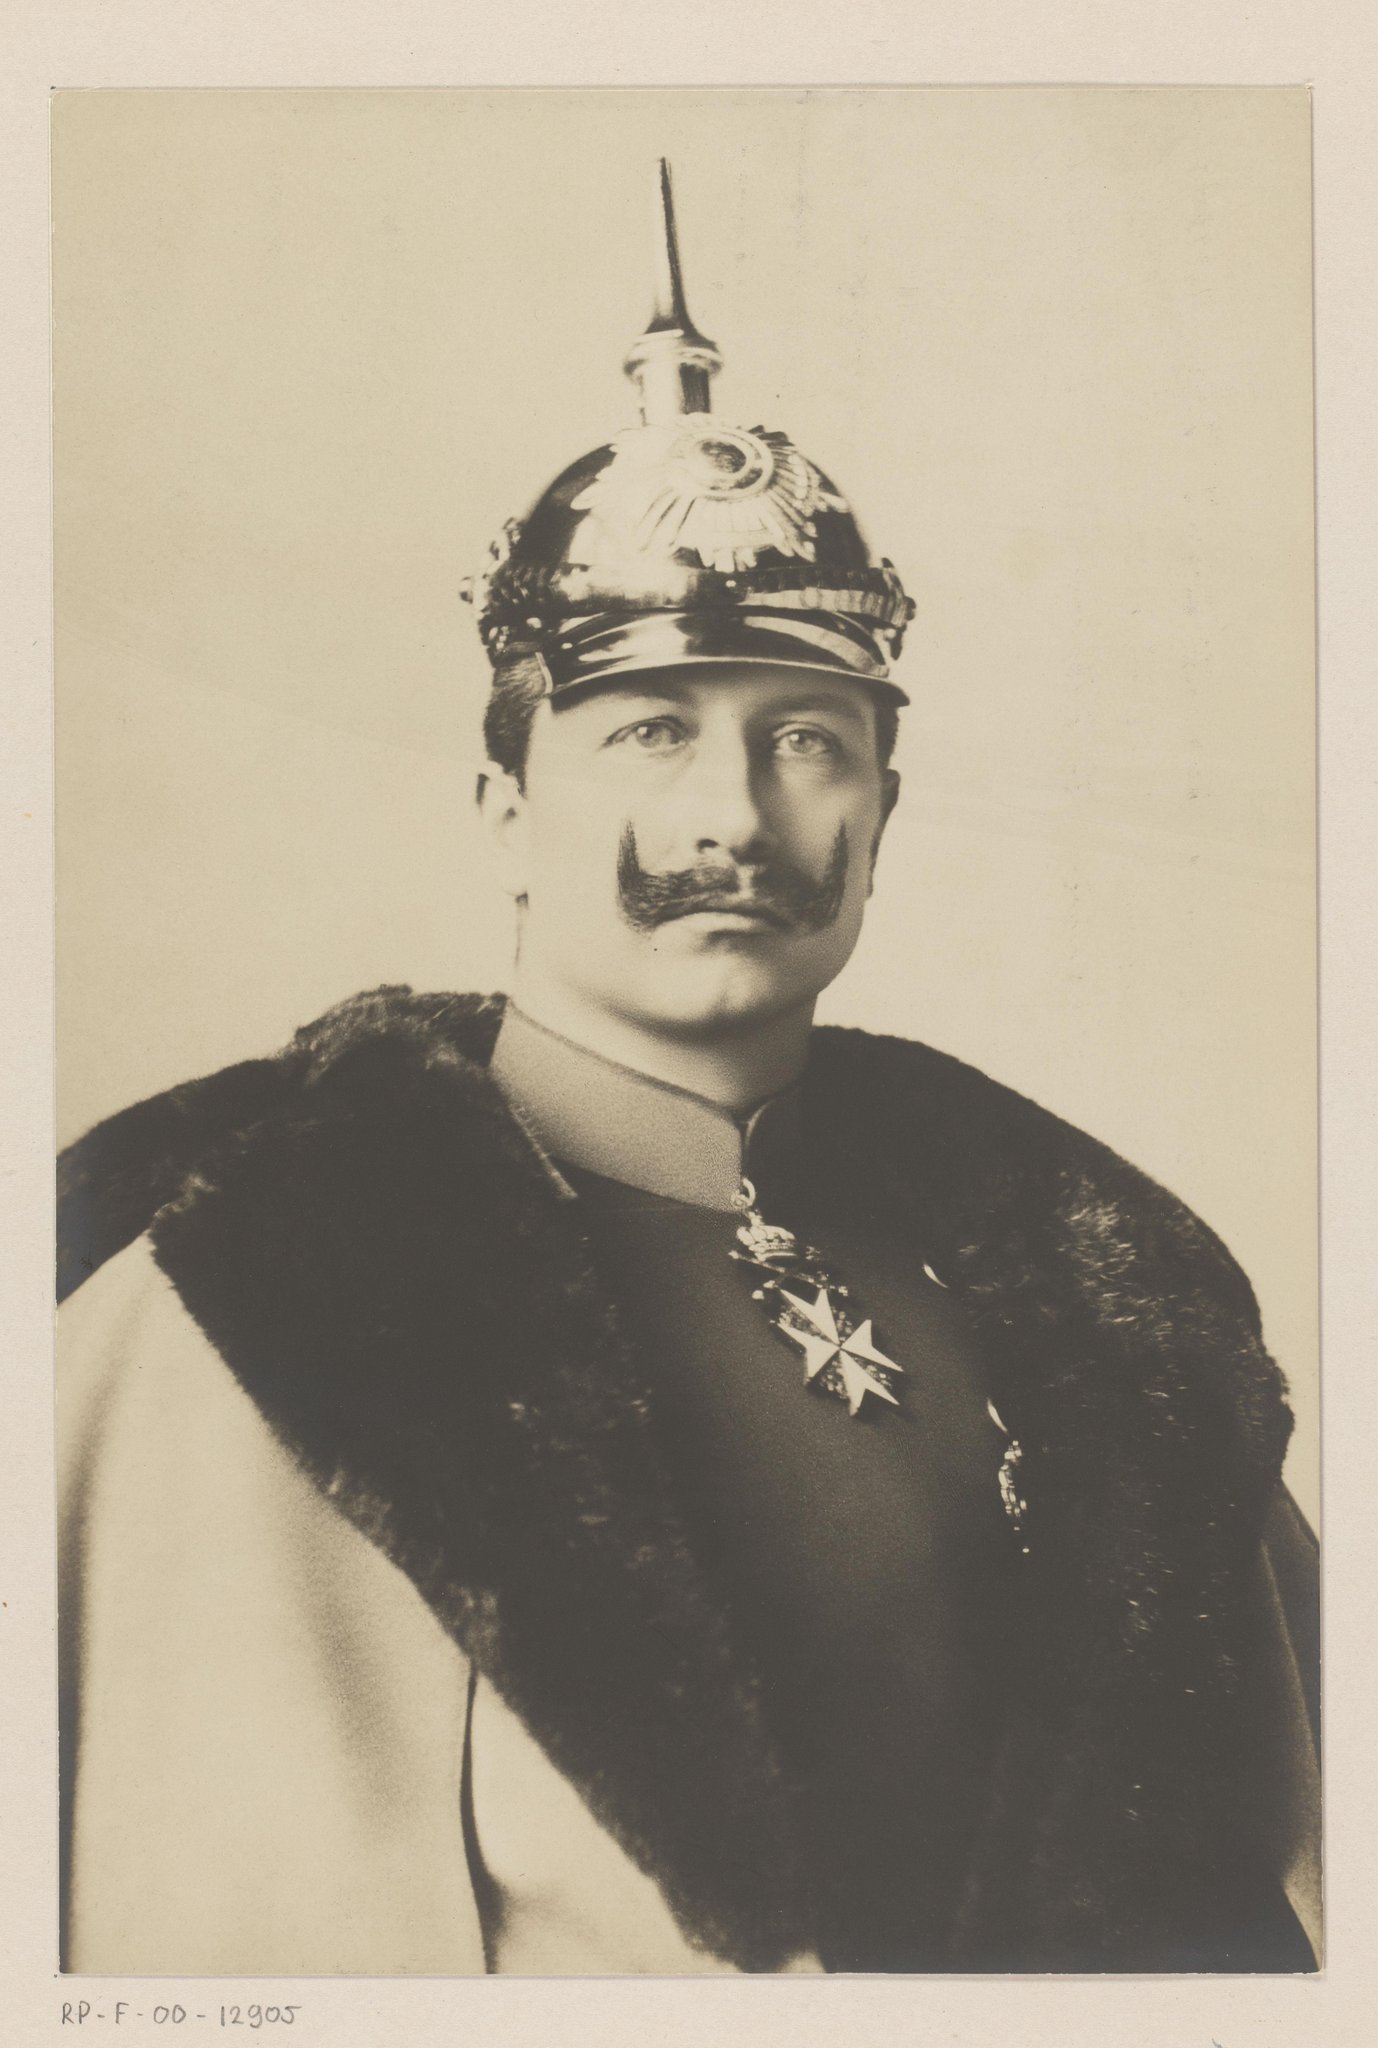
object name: photograph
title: Portret van keizer Wilhelm II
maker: Anonymous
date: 1900-1920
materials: paper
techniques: gelatin silver print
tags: wilhelm ii (keizer van duitsland), historical persons, ruler, sovereign